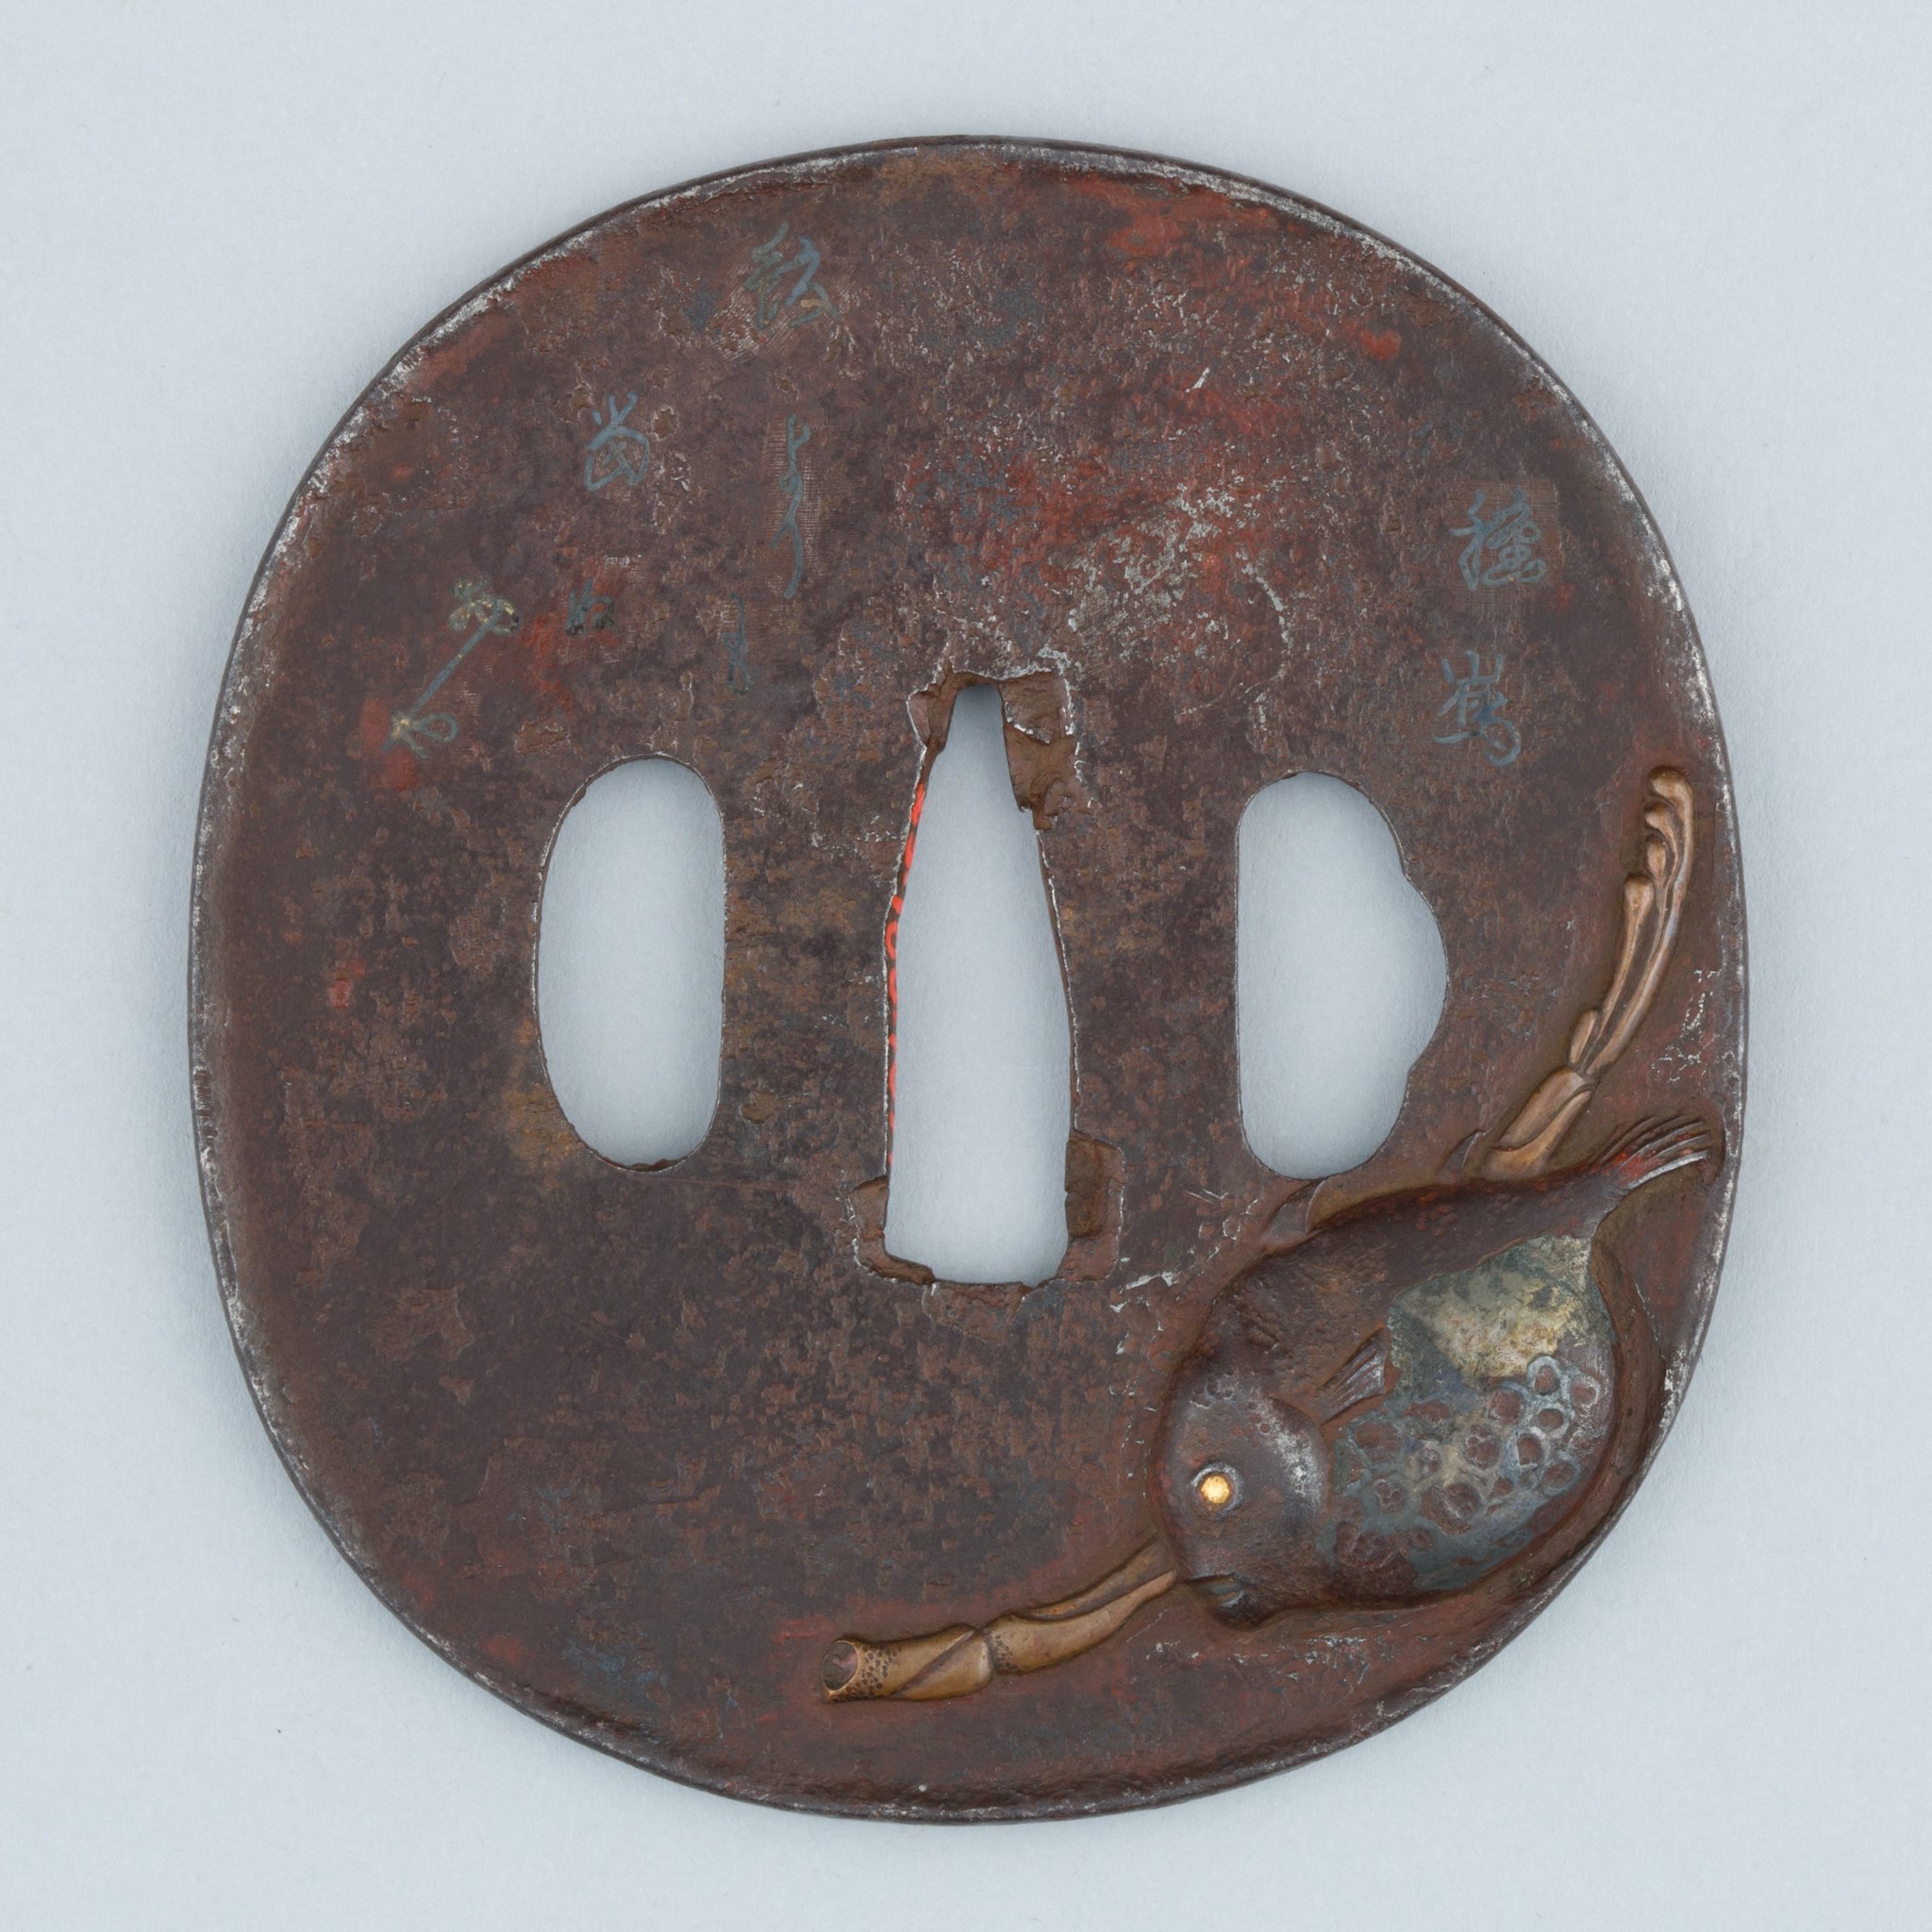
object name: sword guard tsuba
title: Sword Guard (Tsuba)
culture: japanese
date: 1615-1868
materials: copper, iron, pewter, silver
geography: japan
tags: fish